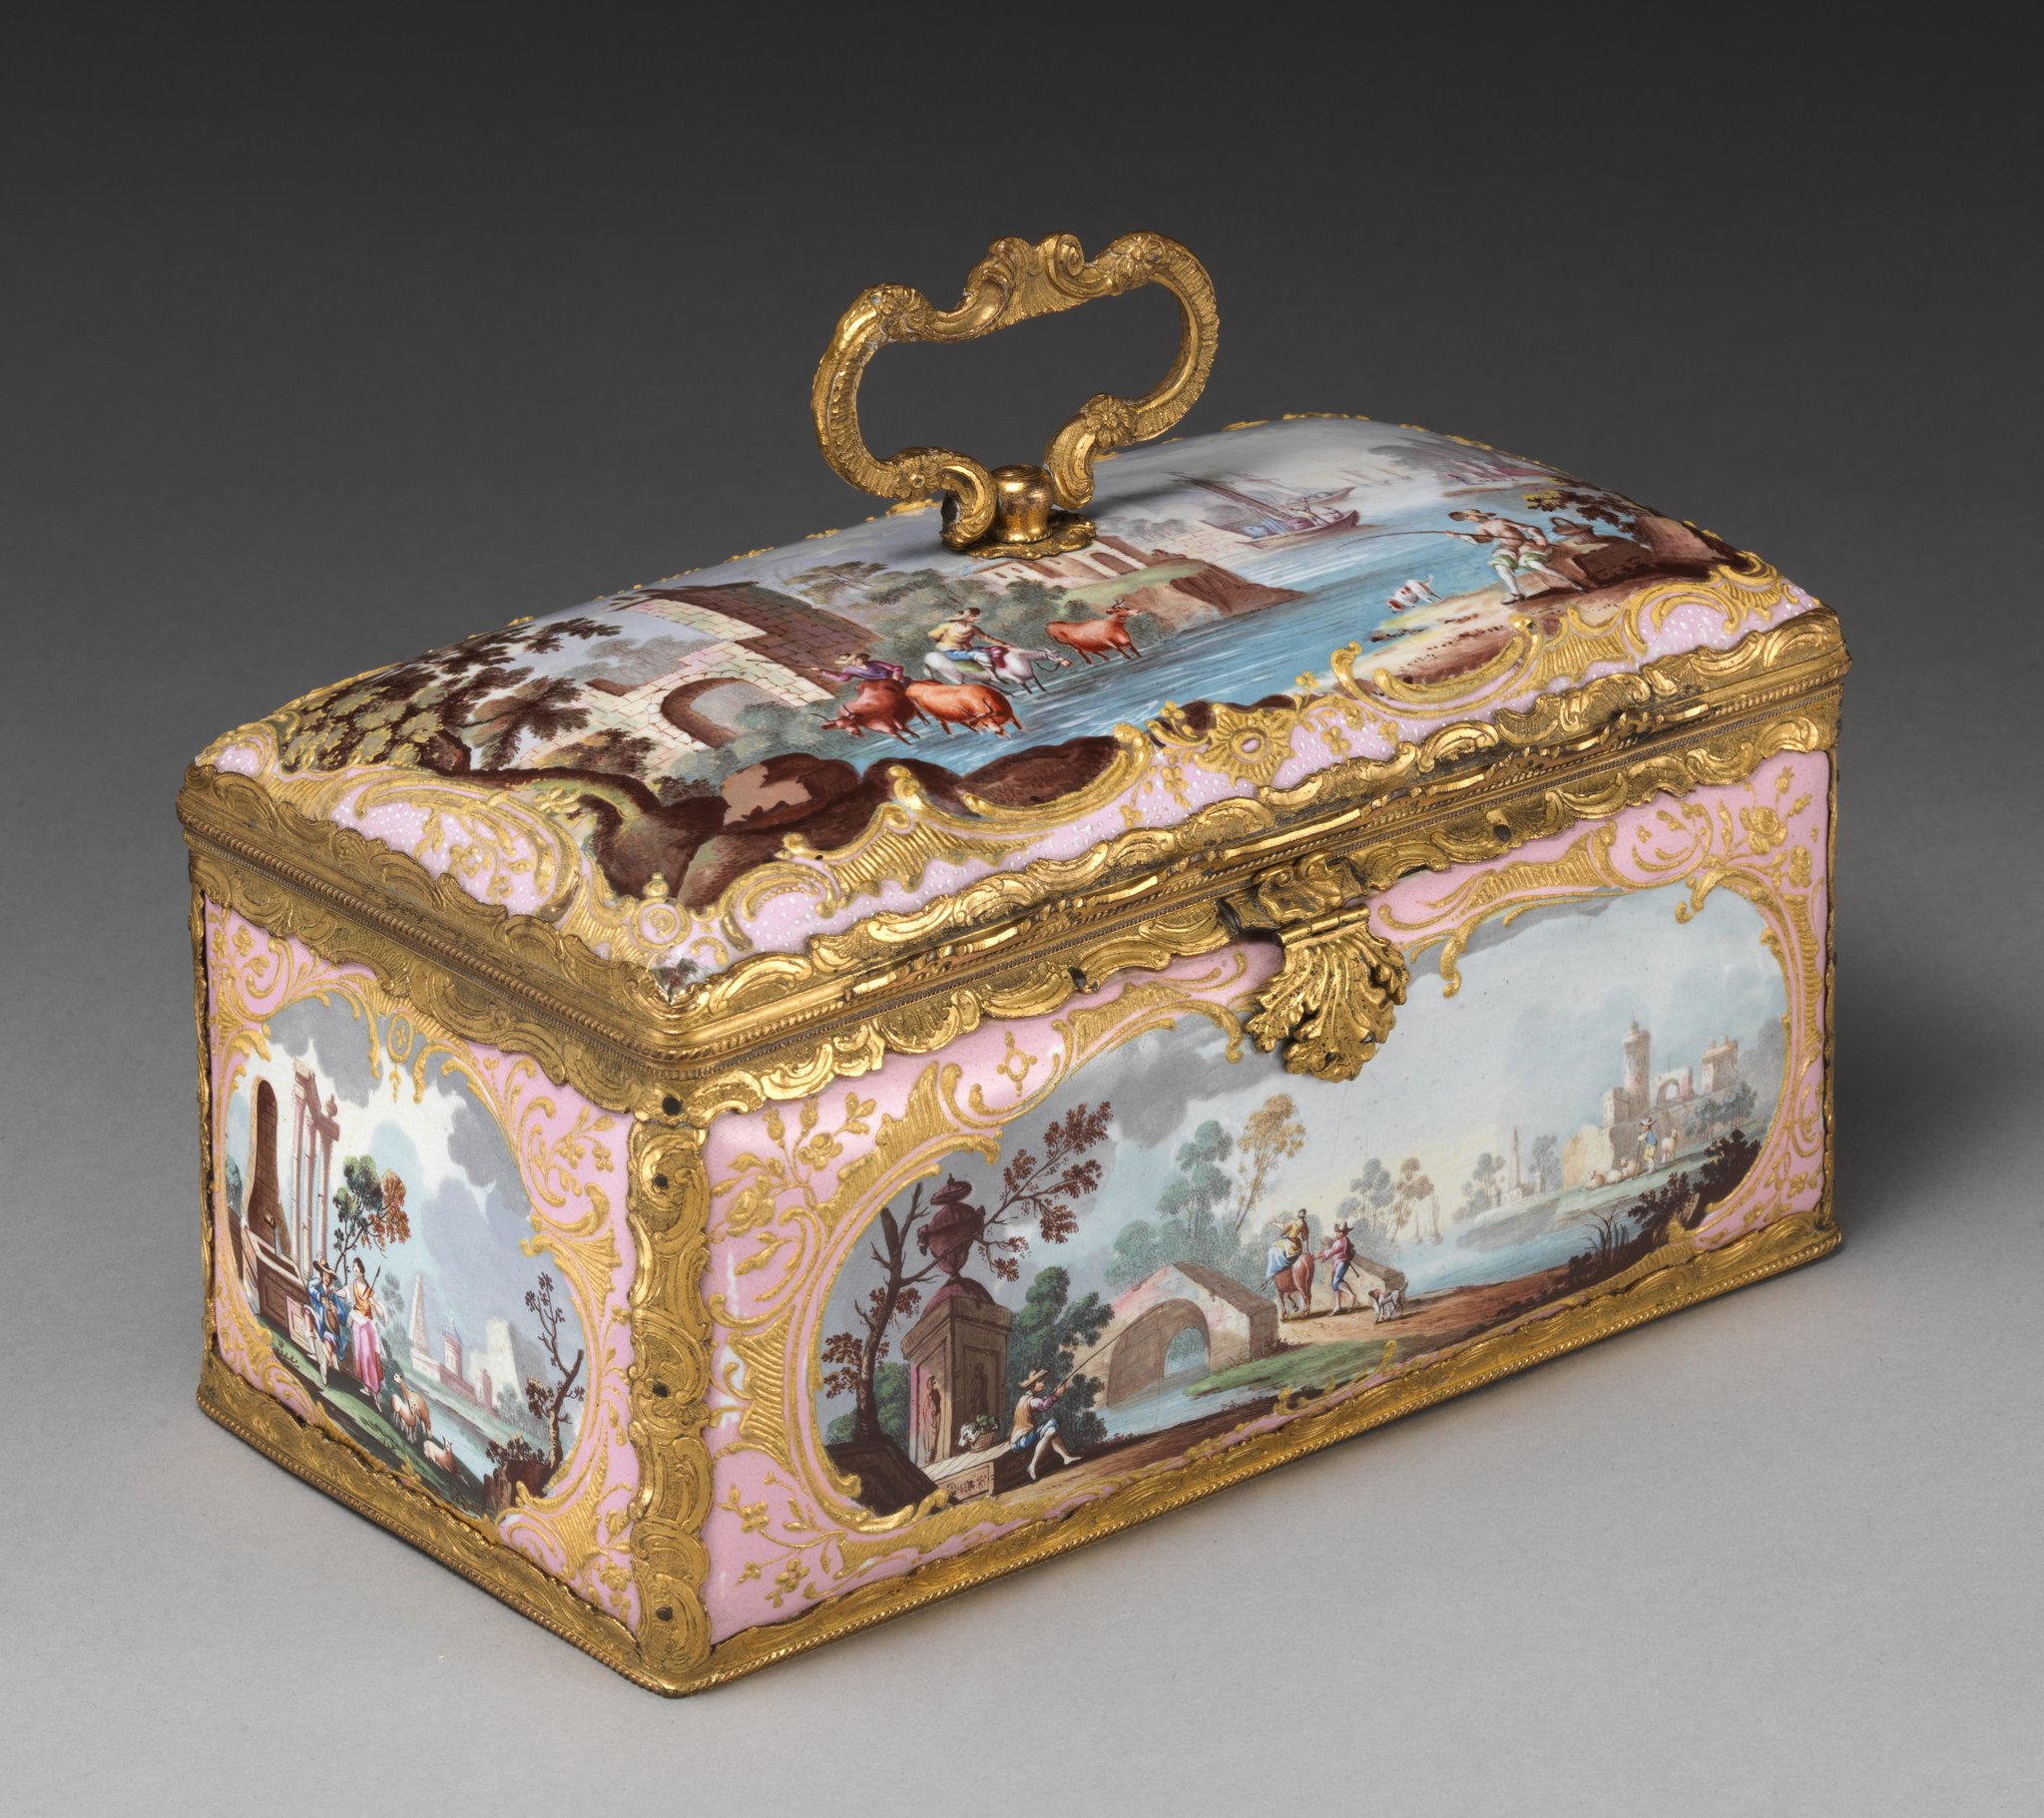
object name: tea casket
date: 1765-1770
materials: copper, enamel, velvet, wood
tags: men,fishing,landscapes